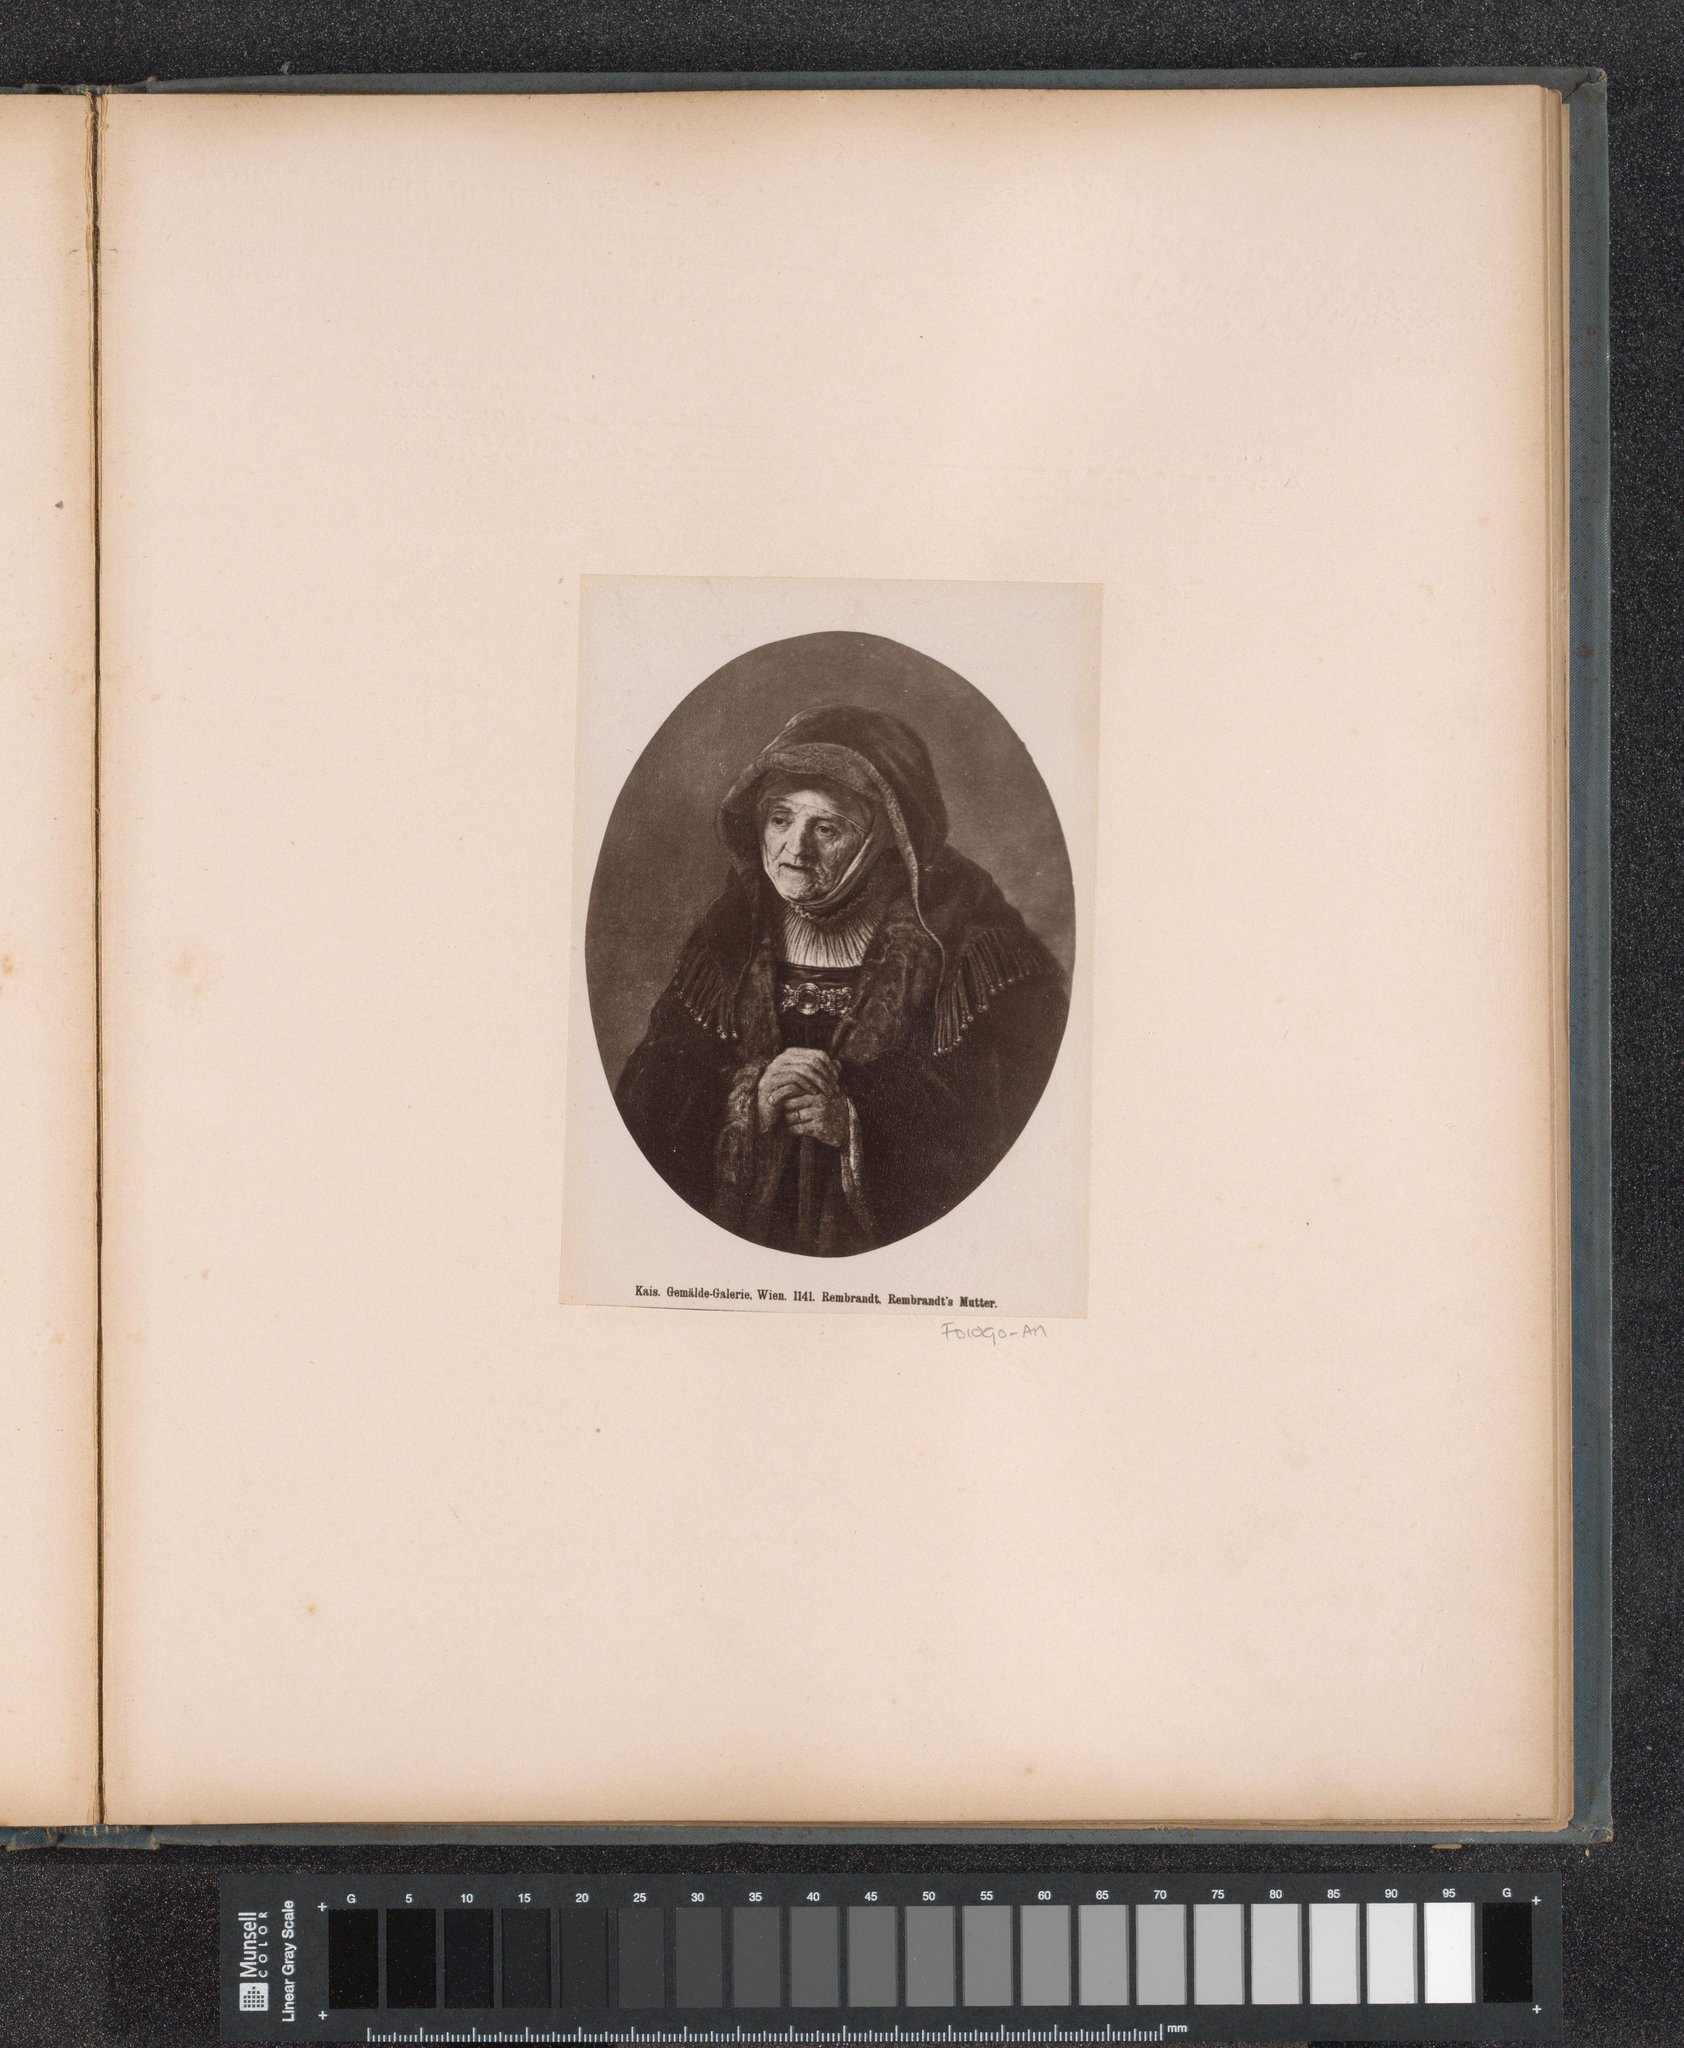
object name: reproduction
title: Fotoreproductie van (vermoedelijk) een prent naar een schilderij van Rembrandt, voorstellend de moeder van de schilder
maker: Anonymous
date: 1870-1900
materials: paper, photographic support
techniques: albumen print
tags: adult woman, old woman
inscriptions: negative number: ‘1141’, check stamp: ‘[...]’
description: Onderdeel van Reisalbum met foto's van bezienswaardigheden in Duitsland en Oostenrijk en van kunstwerken.